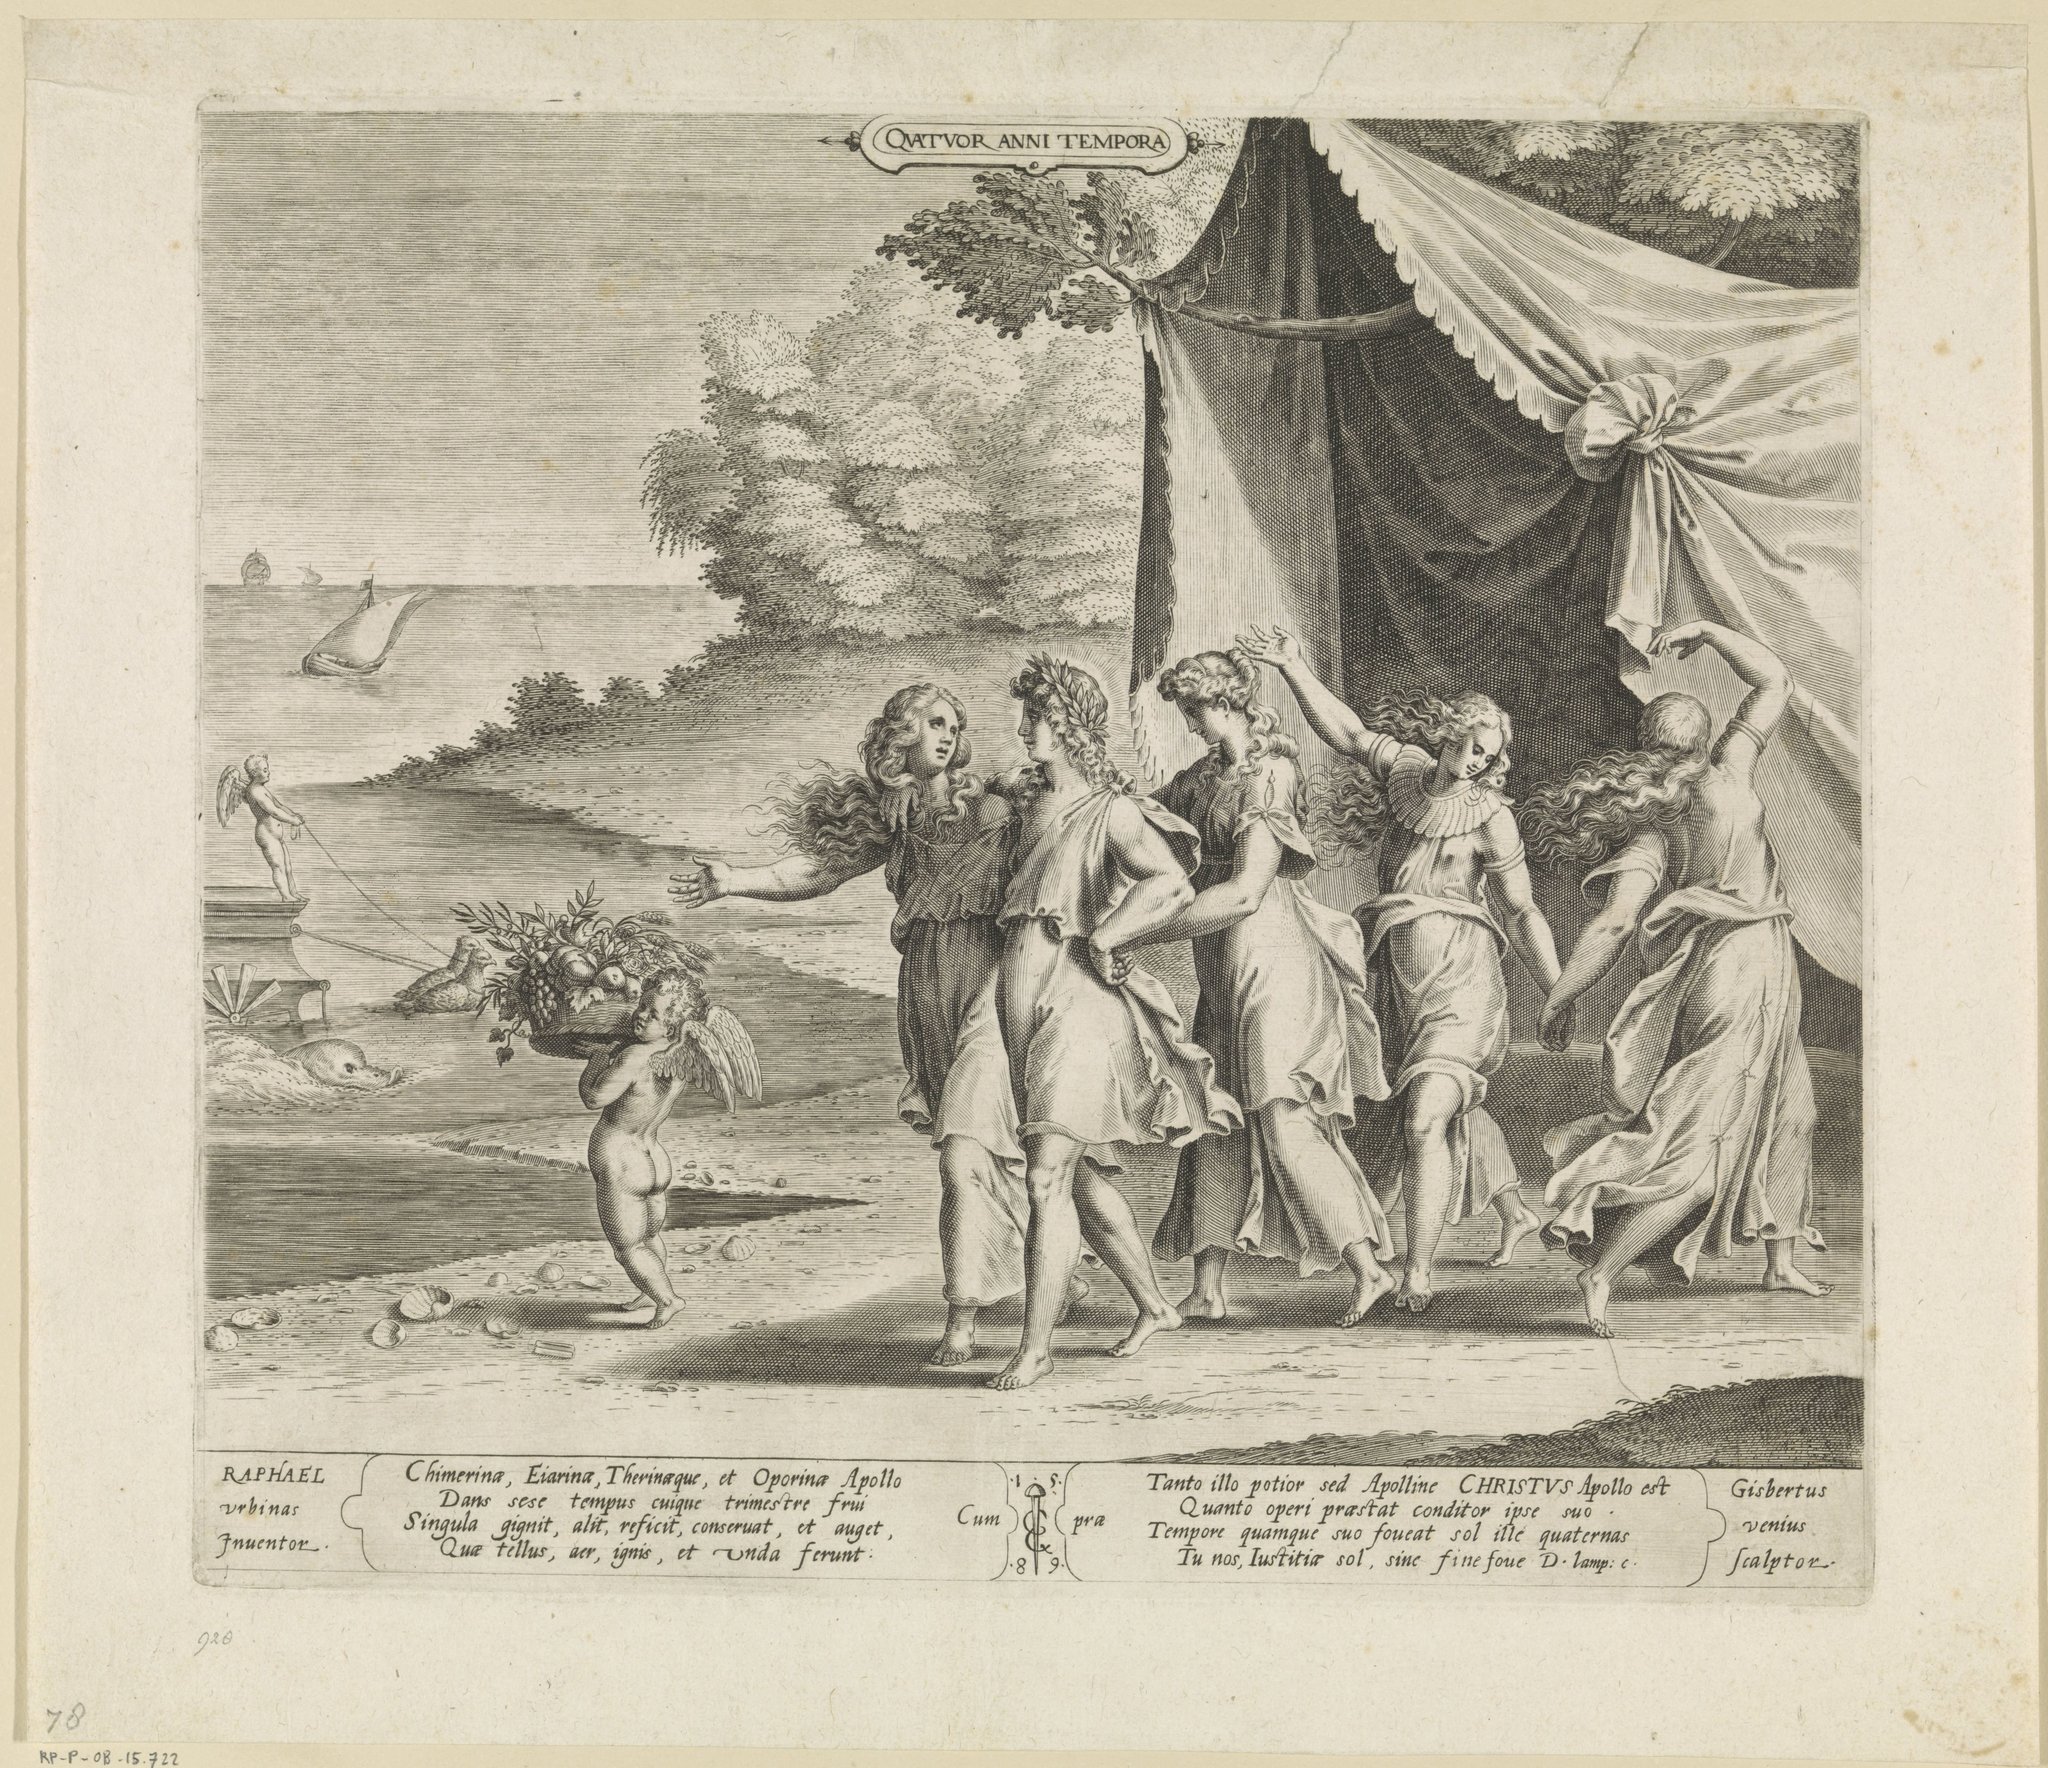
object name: print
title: Quatro anni tempora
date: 1589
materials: paper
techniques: engraving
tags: other specific aspects of apollo, seasons of the year (esp. personifications); 'stagione', 'le quattro stagione dell'anno' (ripa)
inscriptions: caption: ‘Chimerinae, Eiarinae...sine fine foue.’, collector's mark: Lugt 240, signature: ‘Gisbertus / Venius / sculptor’, date: ‘1589’, signature: ‘RAPHAEL / urbinas / Inventor’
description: Apollo als een jongeman getooid met lauwerkrans, lopend voor een grote tent bij een water, geflankeerd door vier jonge vrouwen (de vier seizoenen). Voor het gezelschap loopt een putto met fruitmand. Een vaartuig, getrokken door twee duiven en gemend door een putto in het water.